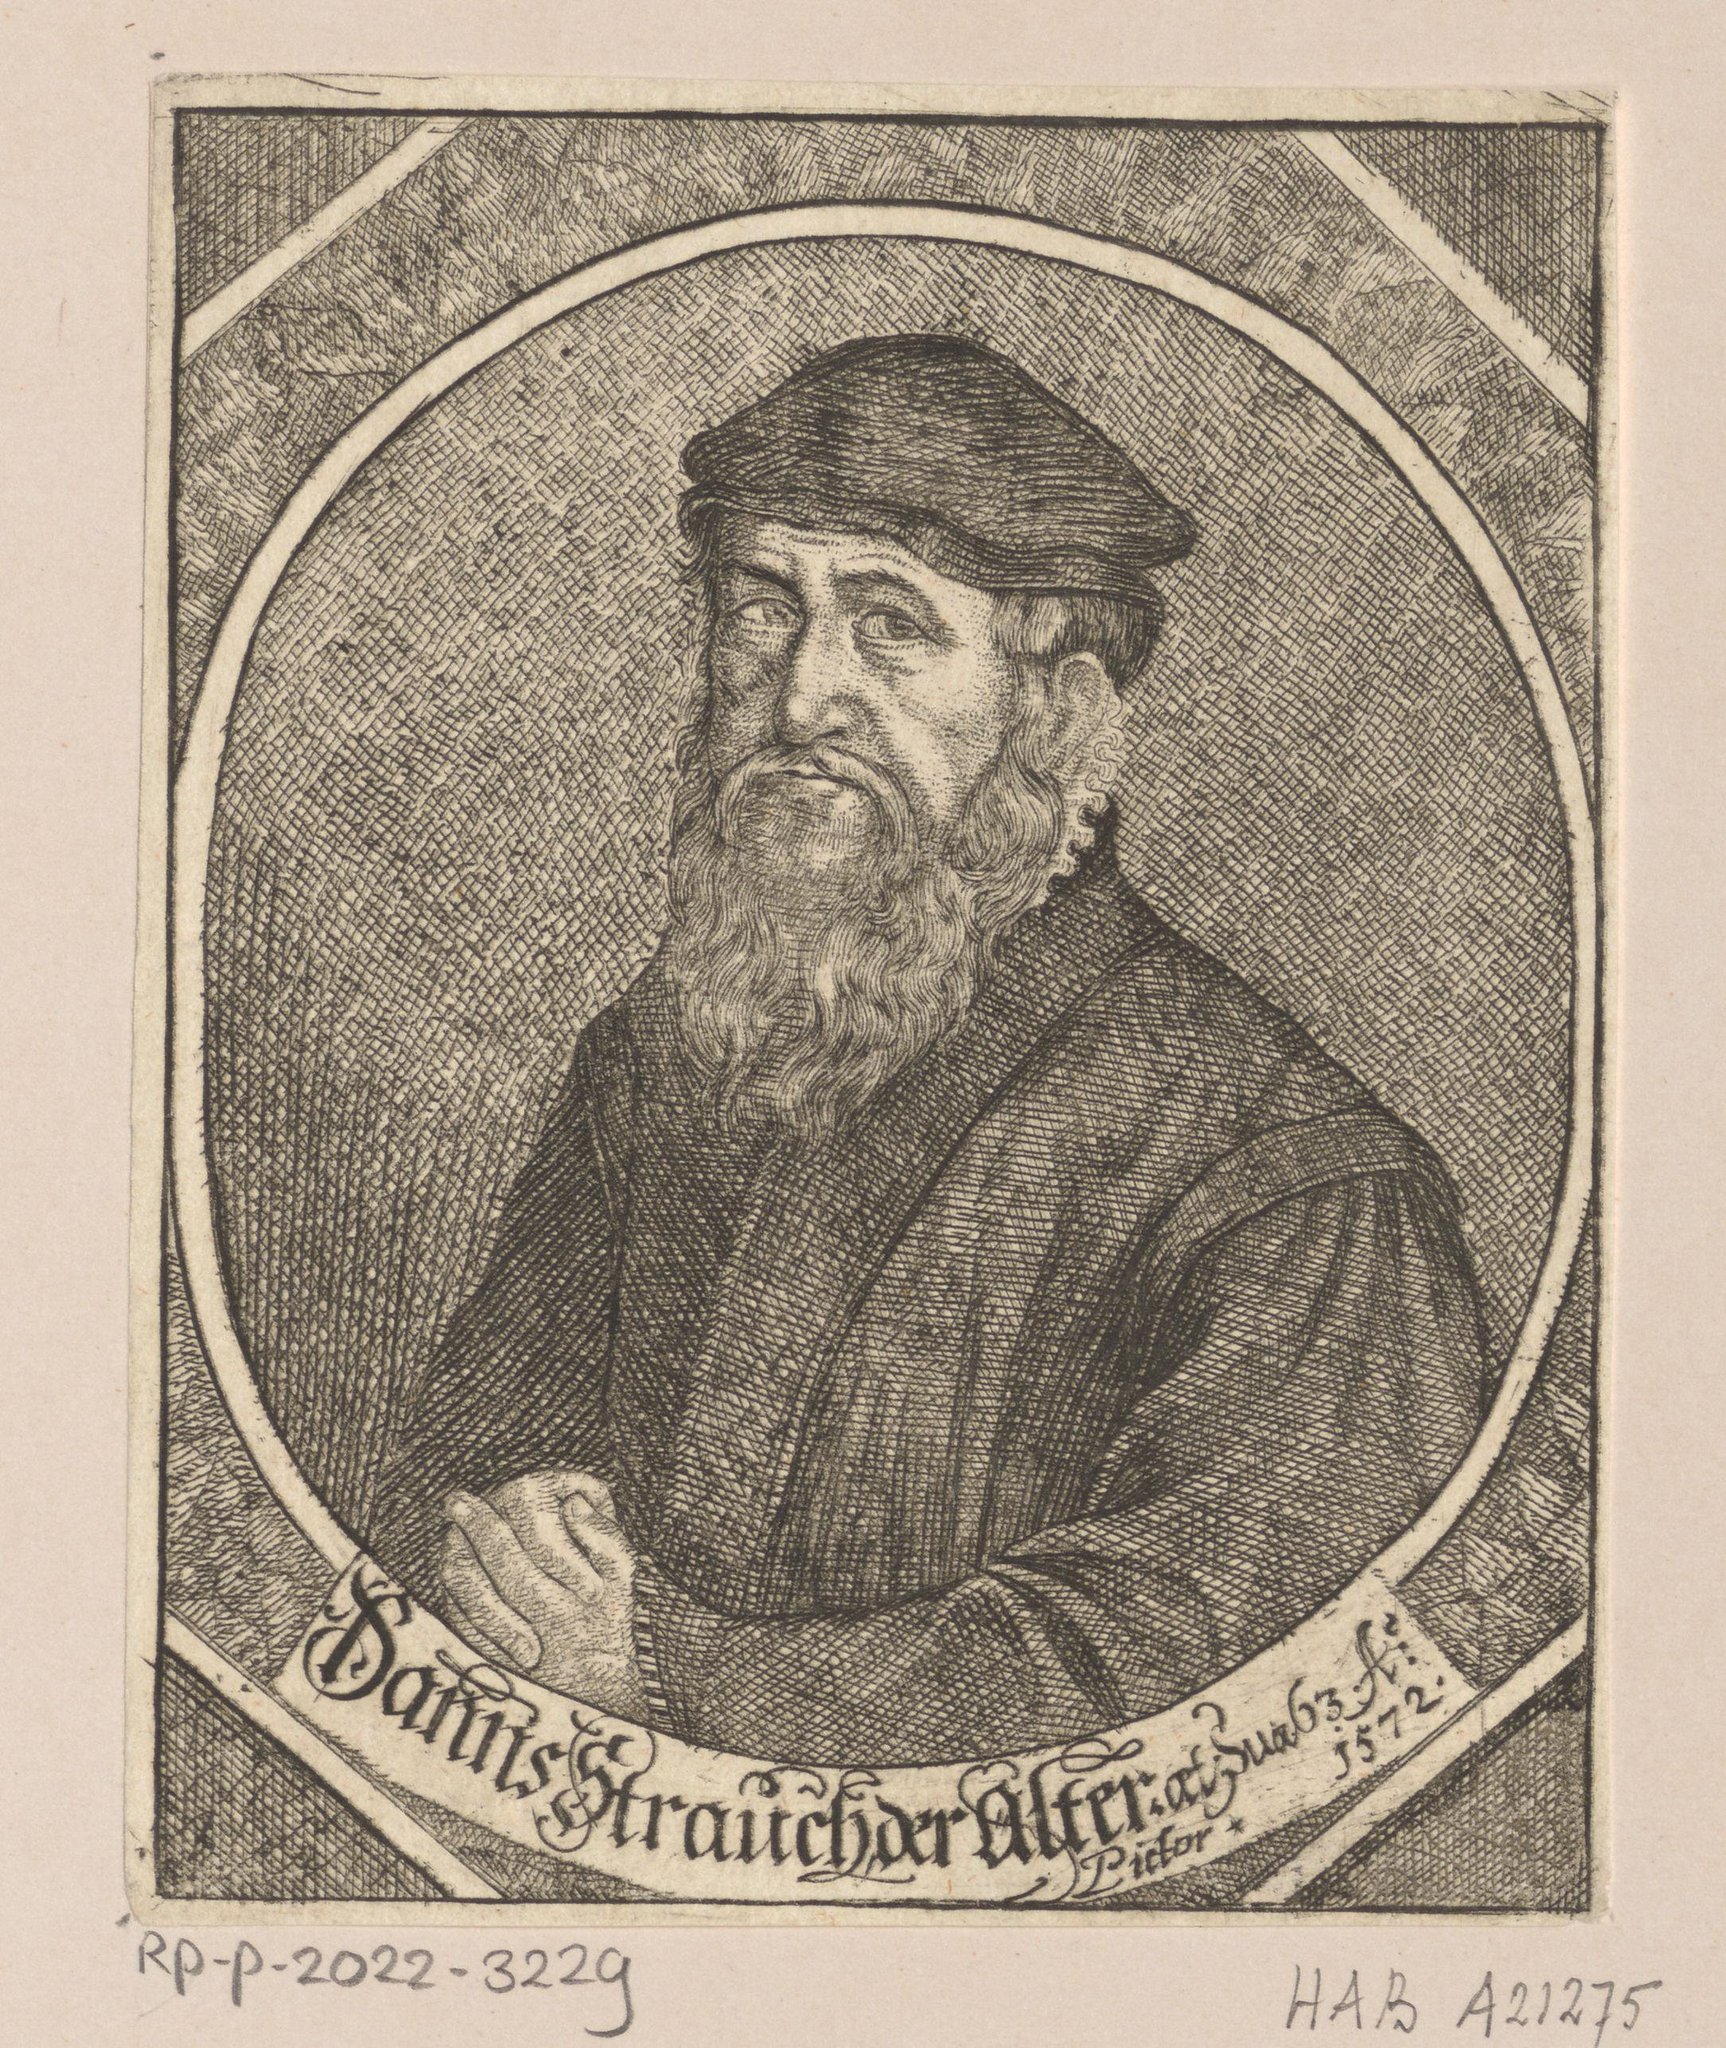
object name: print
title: Portret van Hanns Strauch I op 63-jarige leeftijd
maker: Anonymous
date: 1572-1650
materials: paper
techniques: engraving, etching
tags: historical persons, portrait, self-portrait of artist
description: Met eenregelig onderschrift in het Latijn.